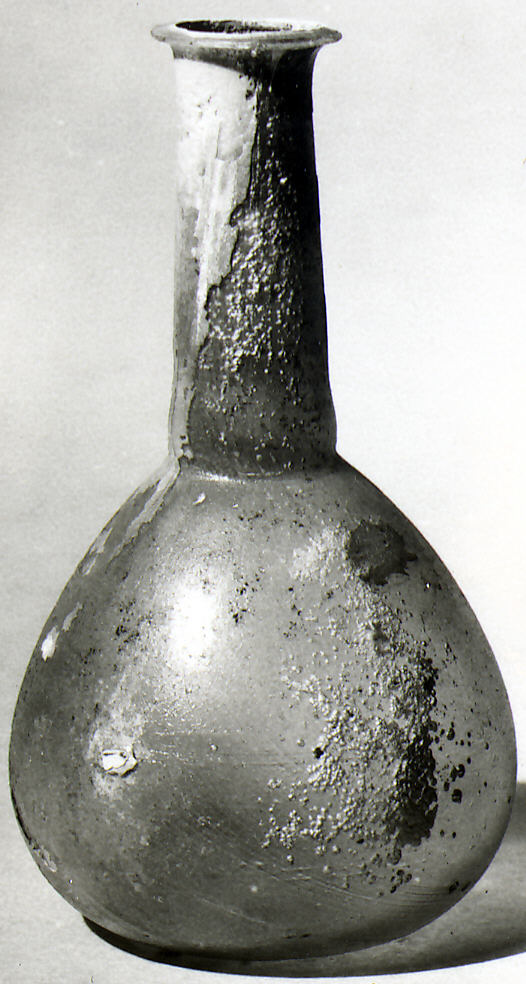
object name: perfume bottle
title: Glass perfume bottle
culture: roman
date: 1-100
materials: glass